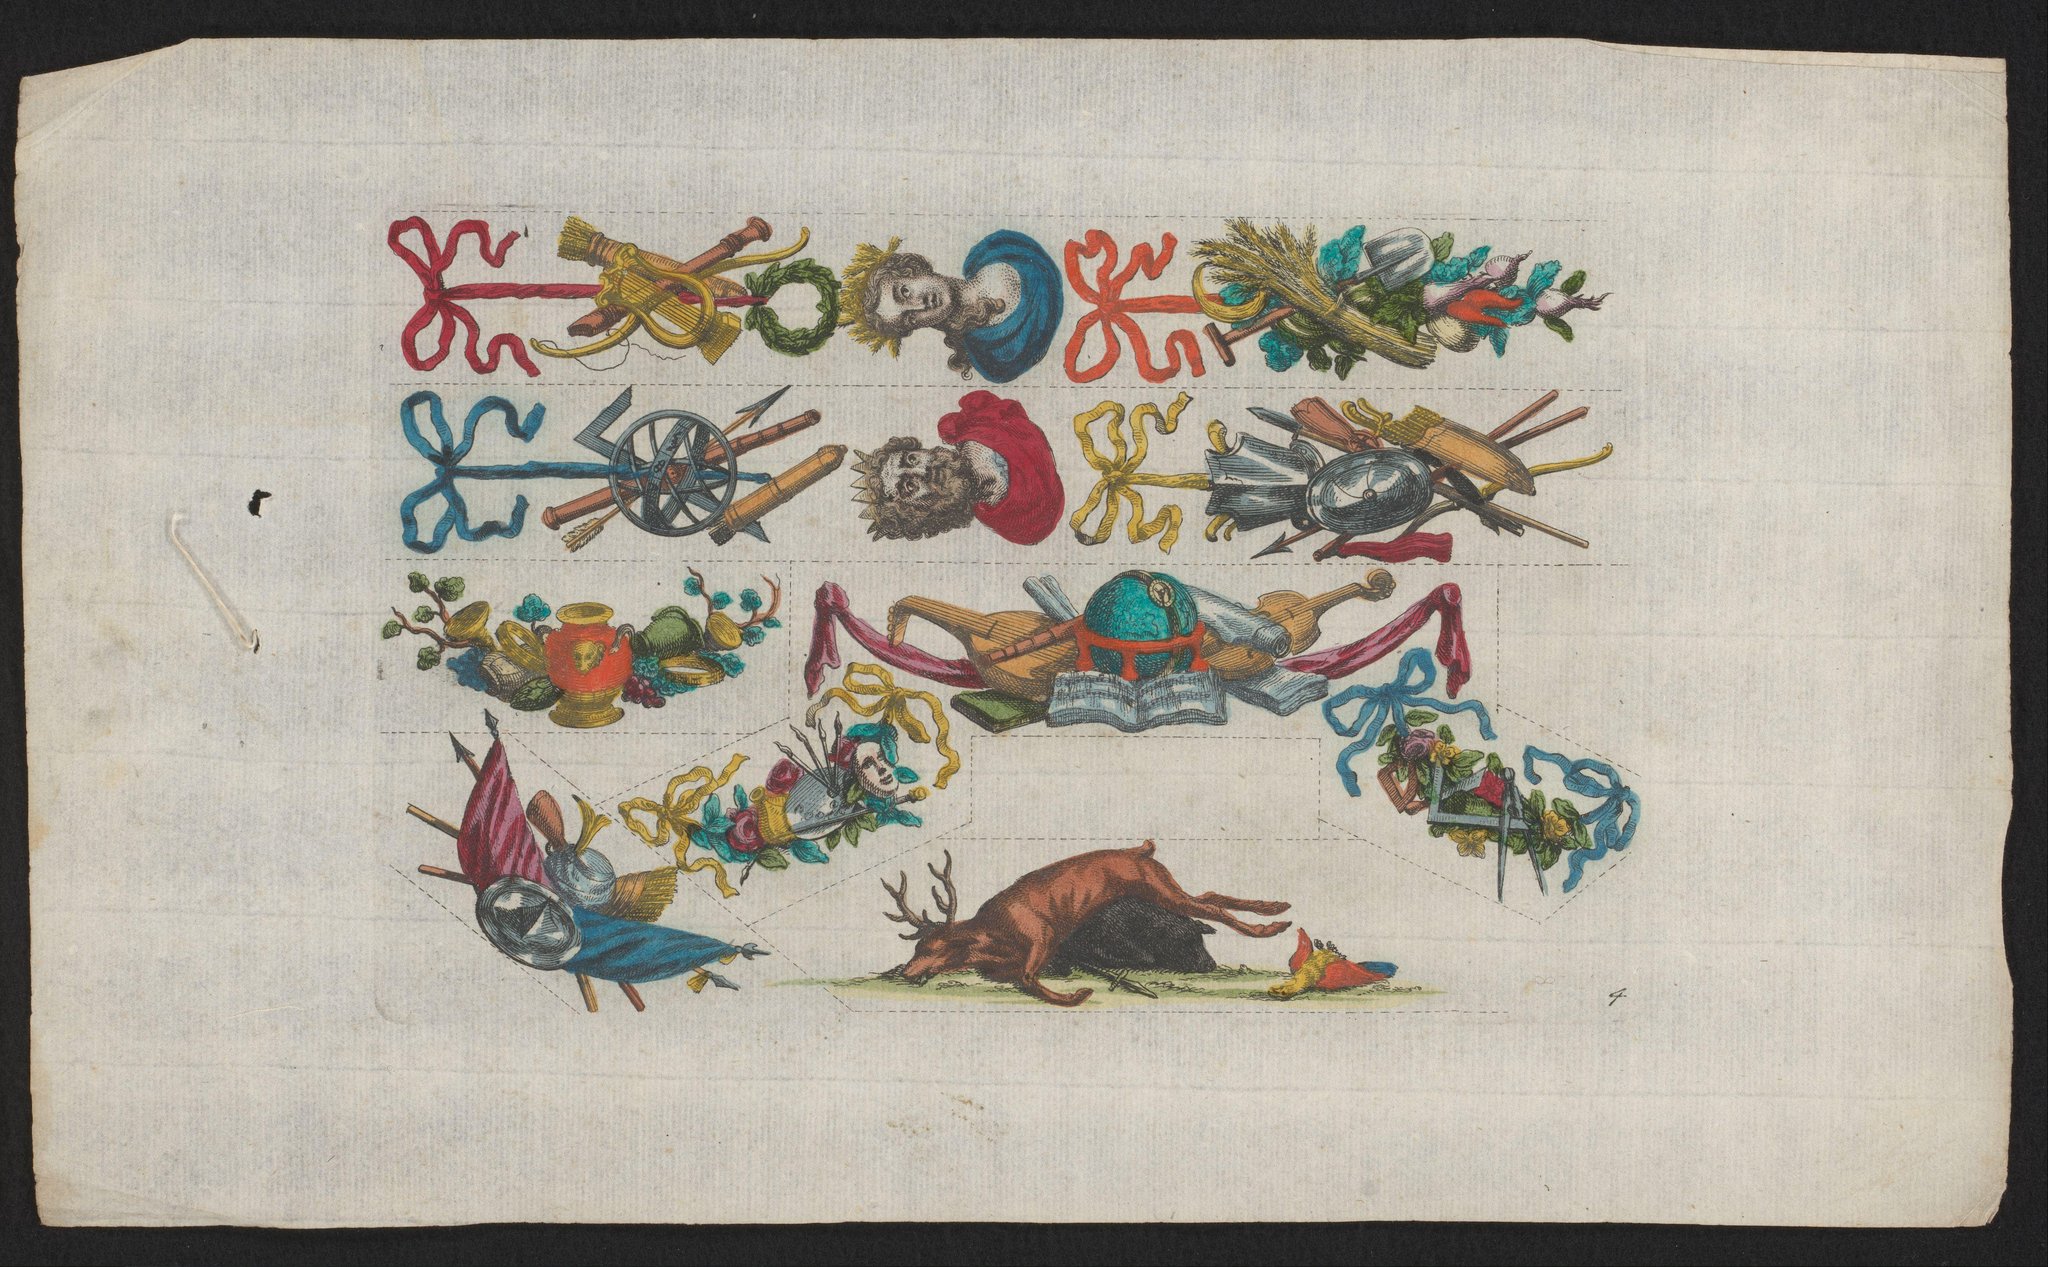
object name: print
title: Knipplaten met figuren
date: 1735-1750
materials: paper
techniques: etching, hand coloring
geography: nuremberg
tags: (story of) ceres (demeter), education, science and learning, animals, art, king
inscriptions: collector's mark: Lugt 2228, collector's mark: Lugt 2760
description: Blad met zes scènes om uit te knippen. Boven Ceres omgeven door een lier, een blokfluit, korenaren en een schep. Daaronder een koning omgeven door meetkundige objecten en wapens. Links midden een vaas. In het midden attributen behorende bij diverse kunsten en wetenschappen. Links onder een schild en wapens. Midden onder een dood hert, zwijn en vogel.